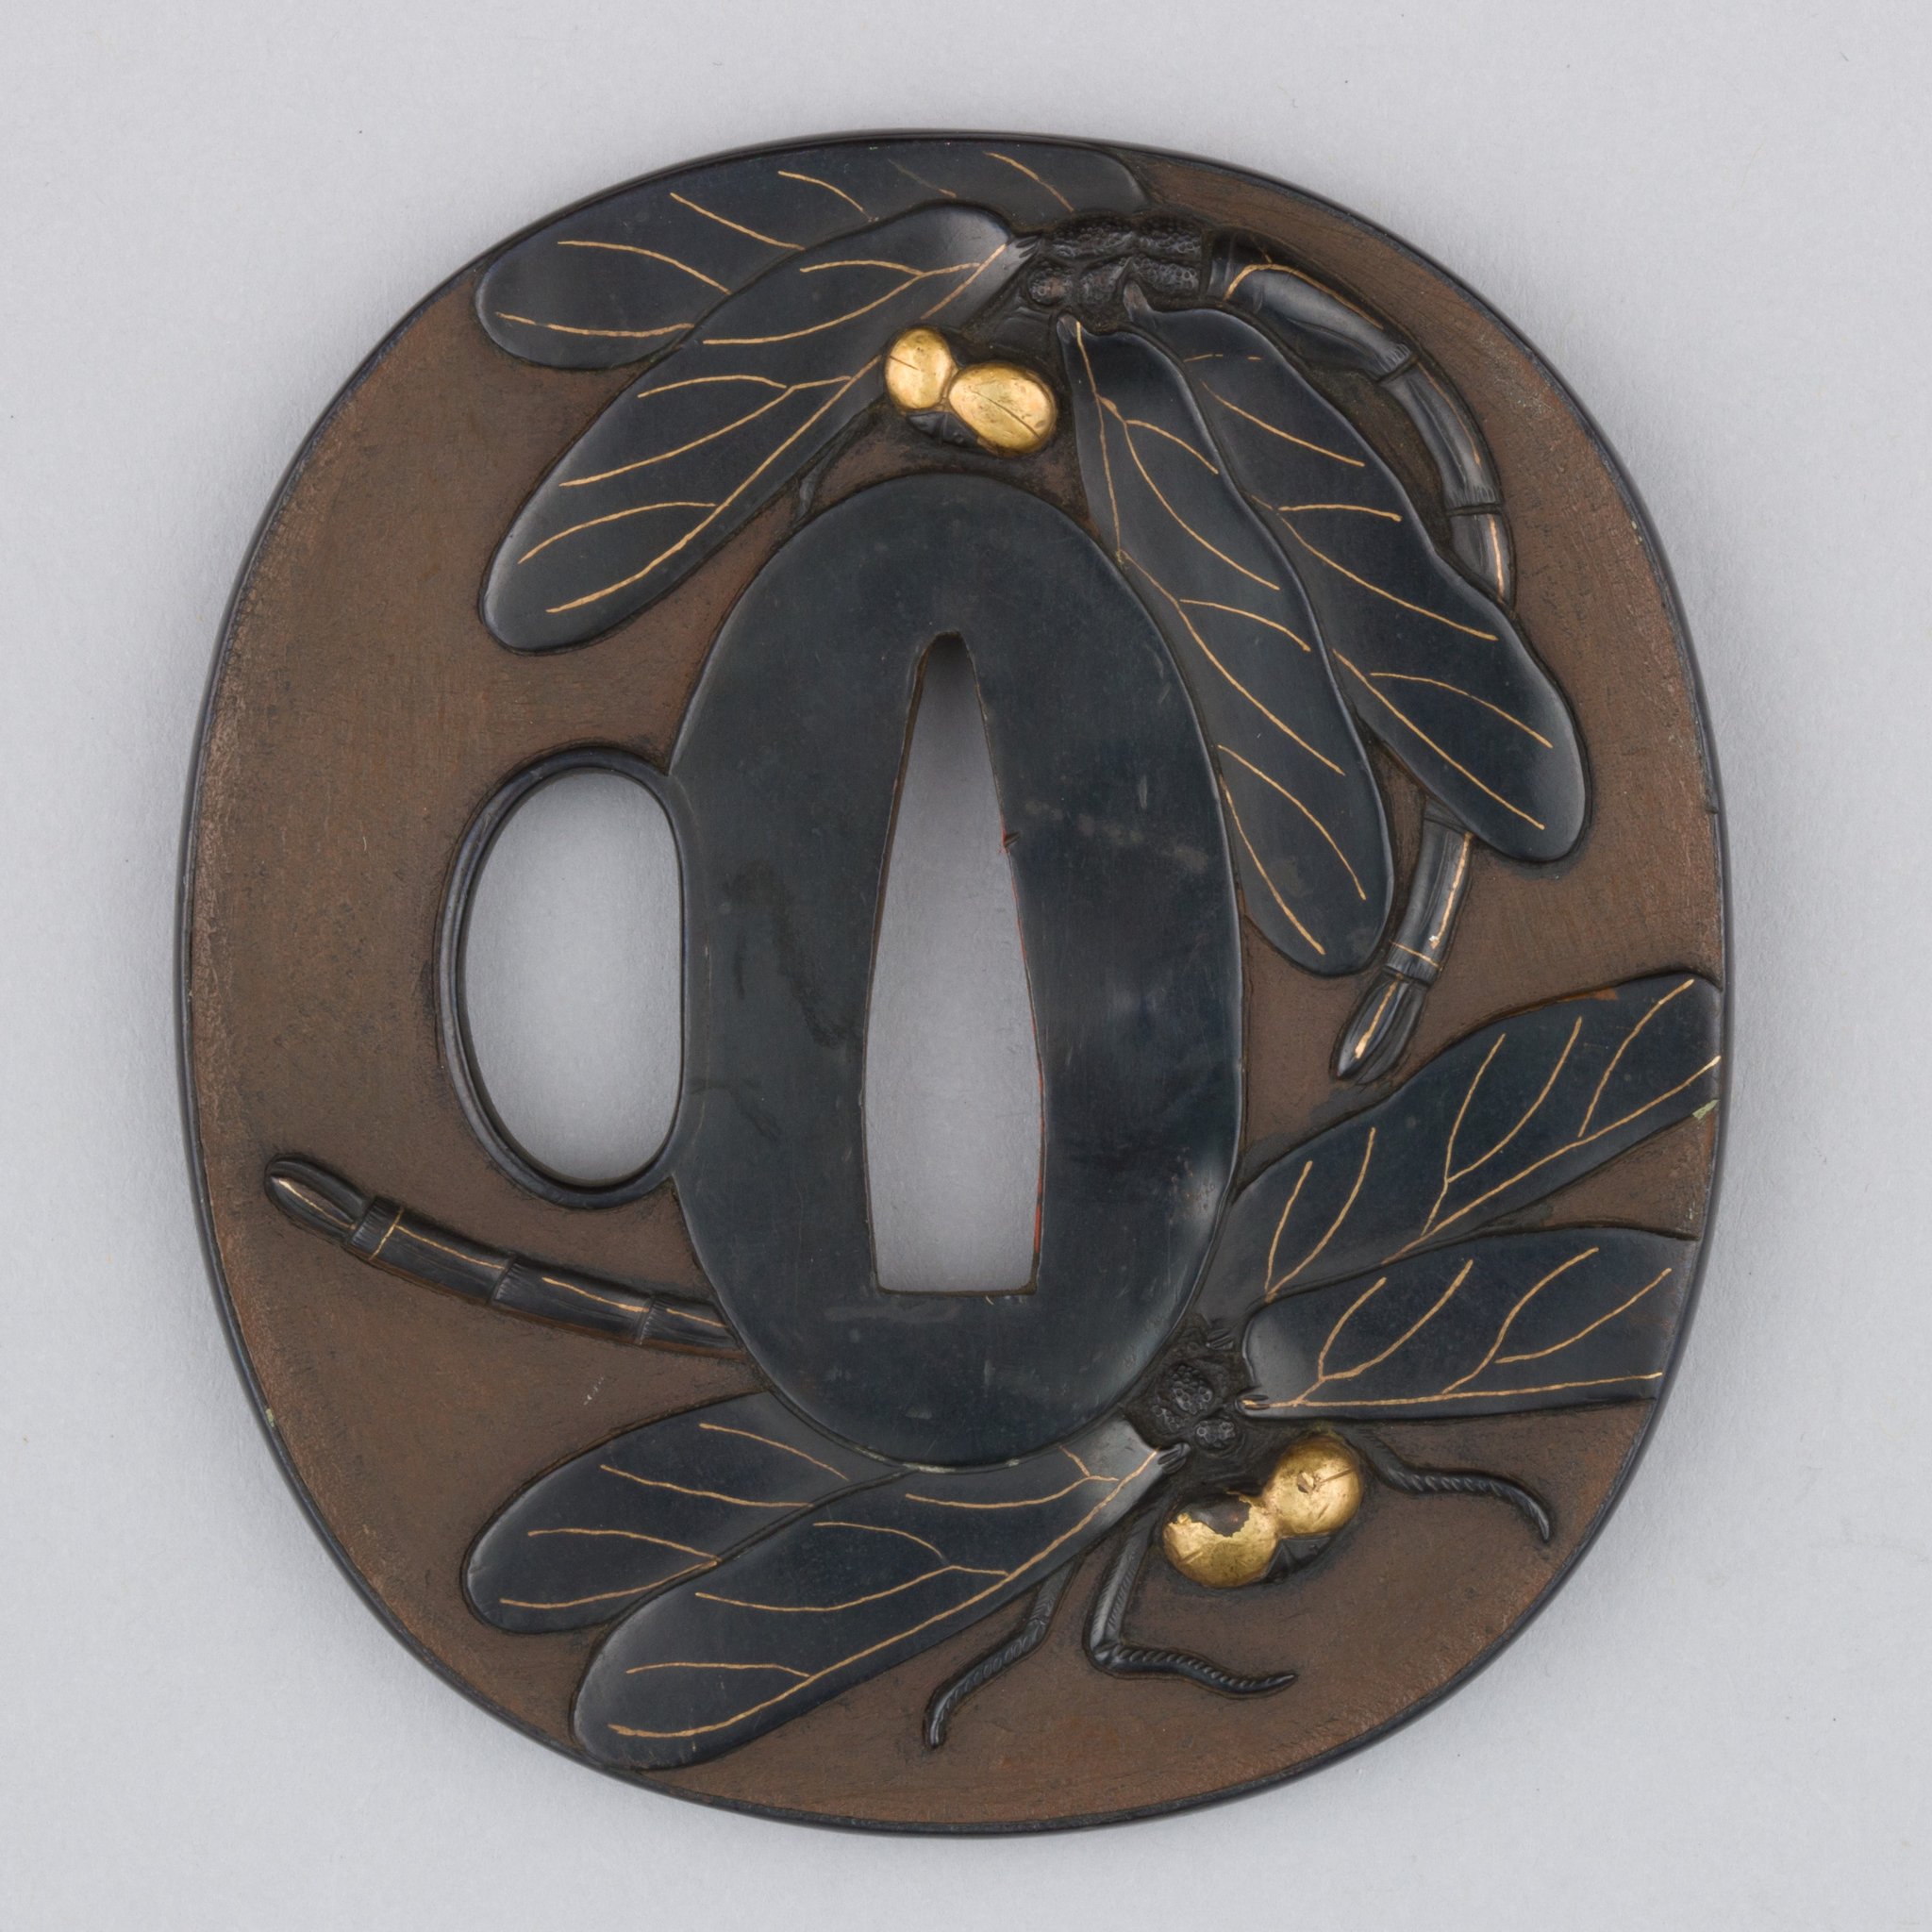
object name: sword guard tsuba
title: Sword Guard (Tsuba)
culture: japanese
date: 1615-1868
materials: copper, gold alloy, gold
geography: japan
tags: dragonflies